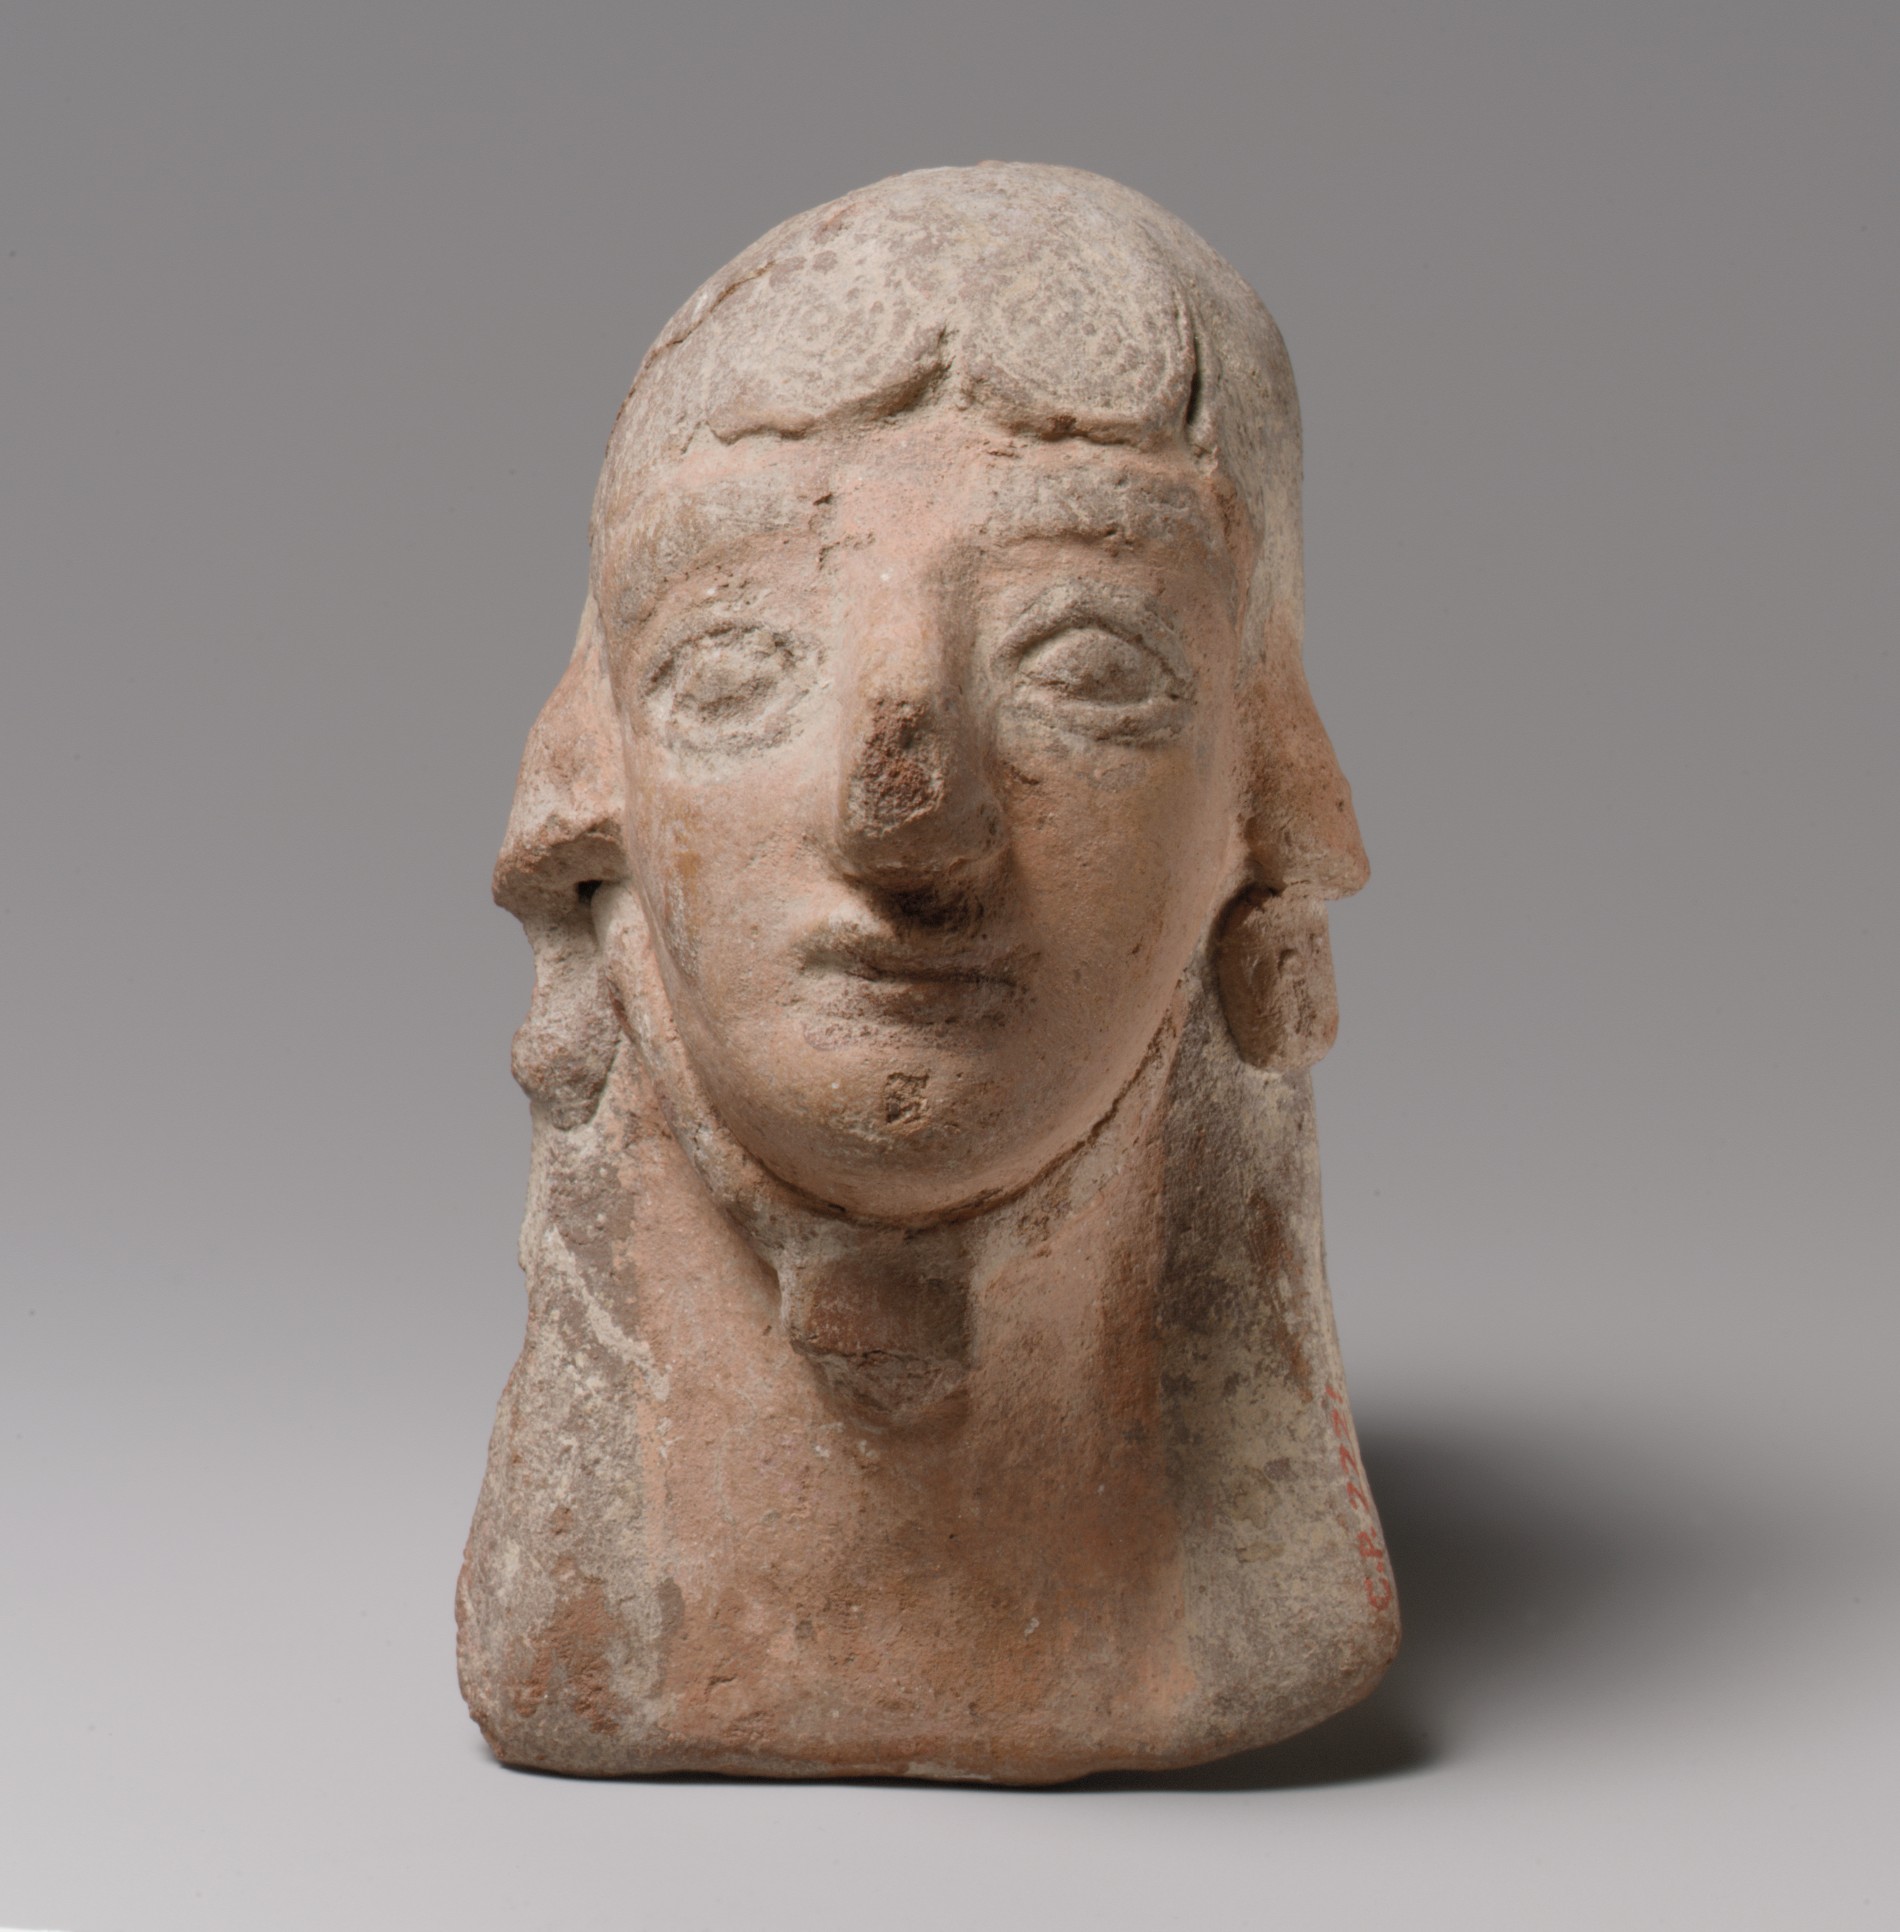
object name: bust of a woman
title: Female protome-mask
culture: cypriot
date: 600-480 BCE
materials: terracotta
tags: masks,women